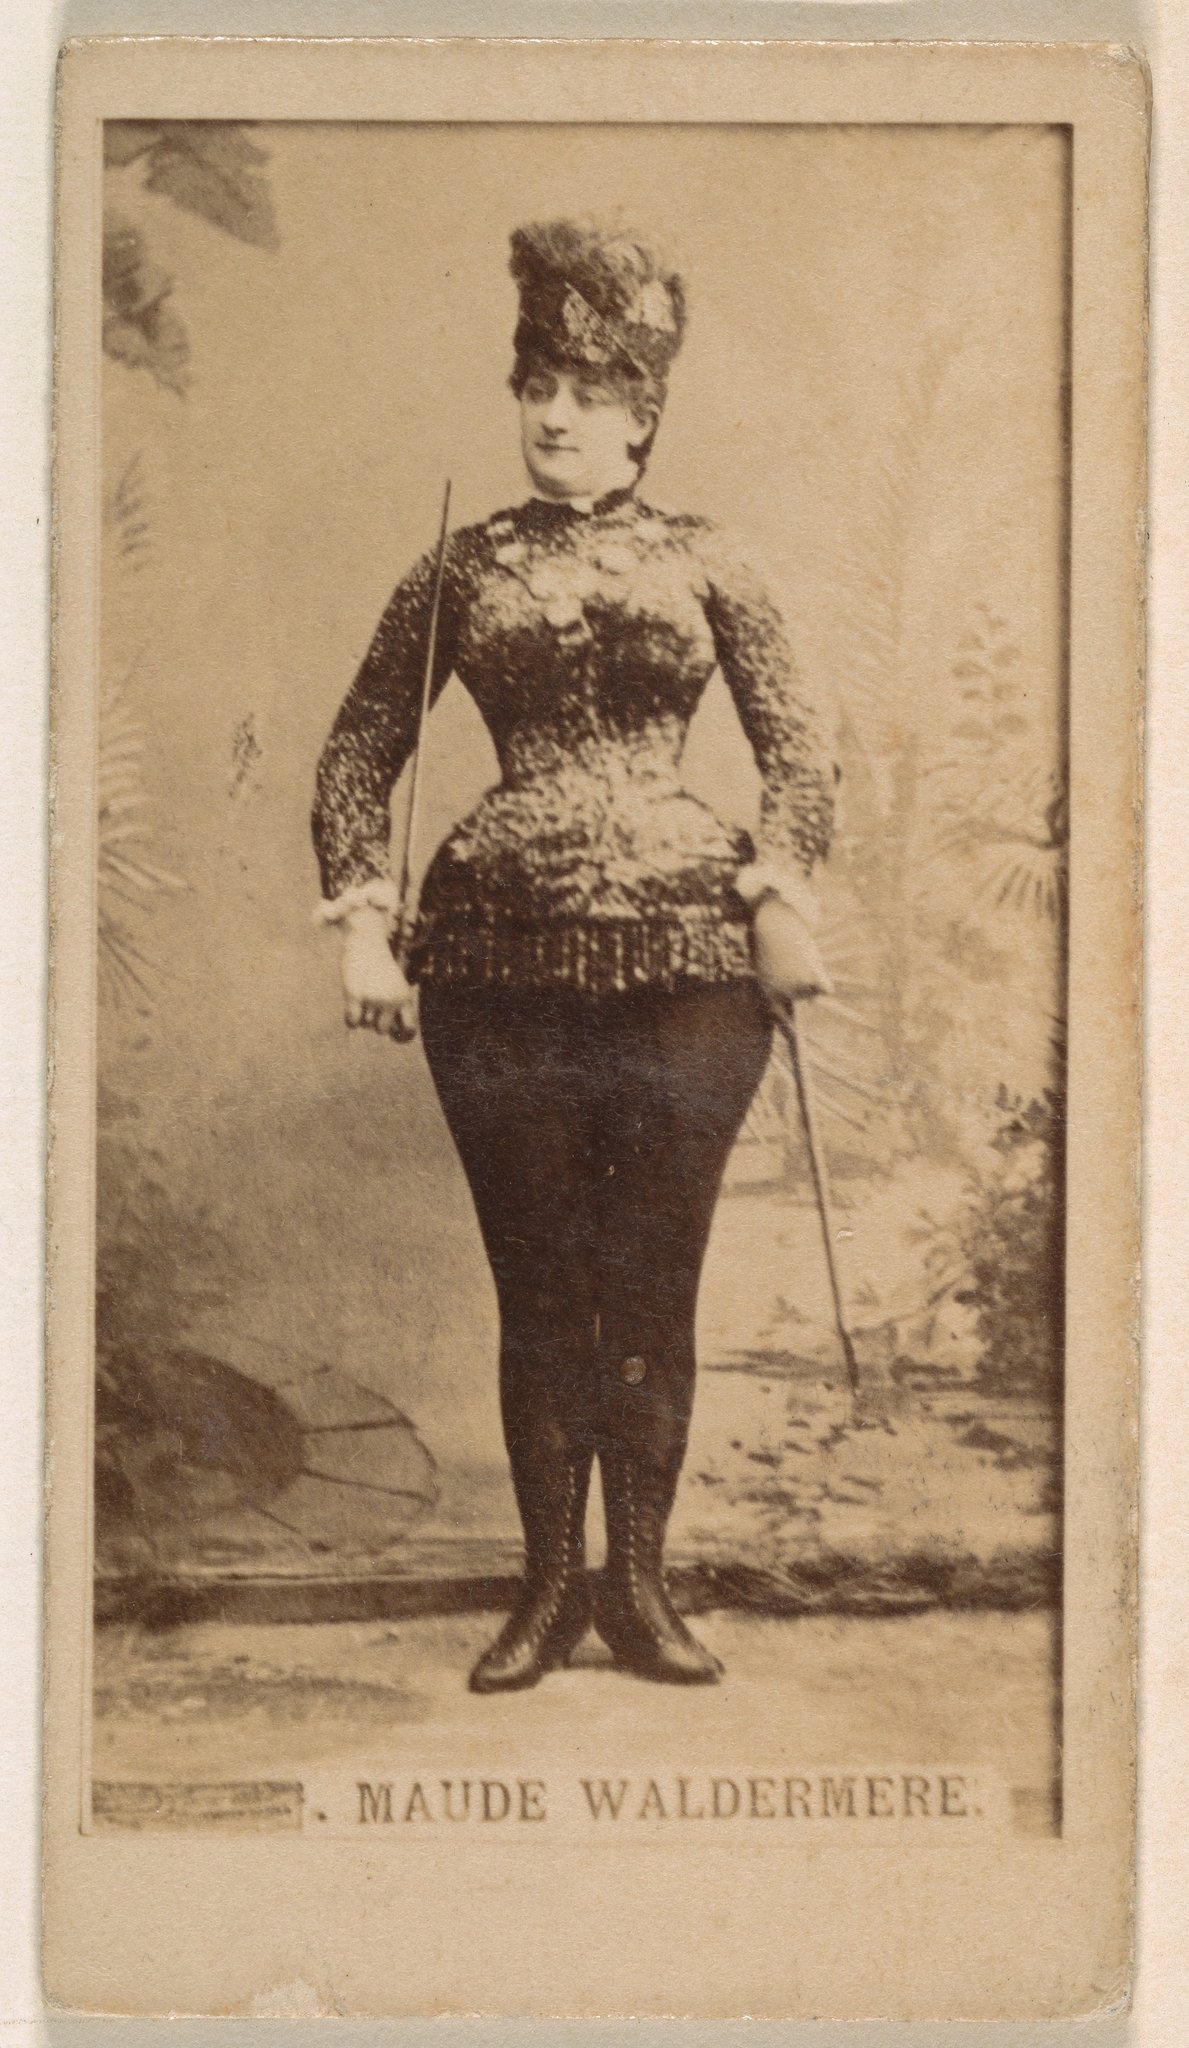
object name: photograph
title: Maude Waldermere, from the Actresses series (N245) issued by Kinney Brothers to promote Sweet Caporal Cigarettes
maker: kinney brothers tobacco company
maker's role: publisher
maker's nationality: american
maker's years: 1869-2011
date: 1890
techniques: albumen silver print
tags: portraits,women,actresses